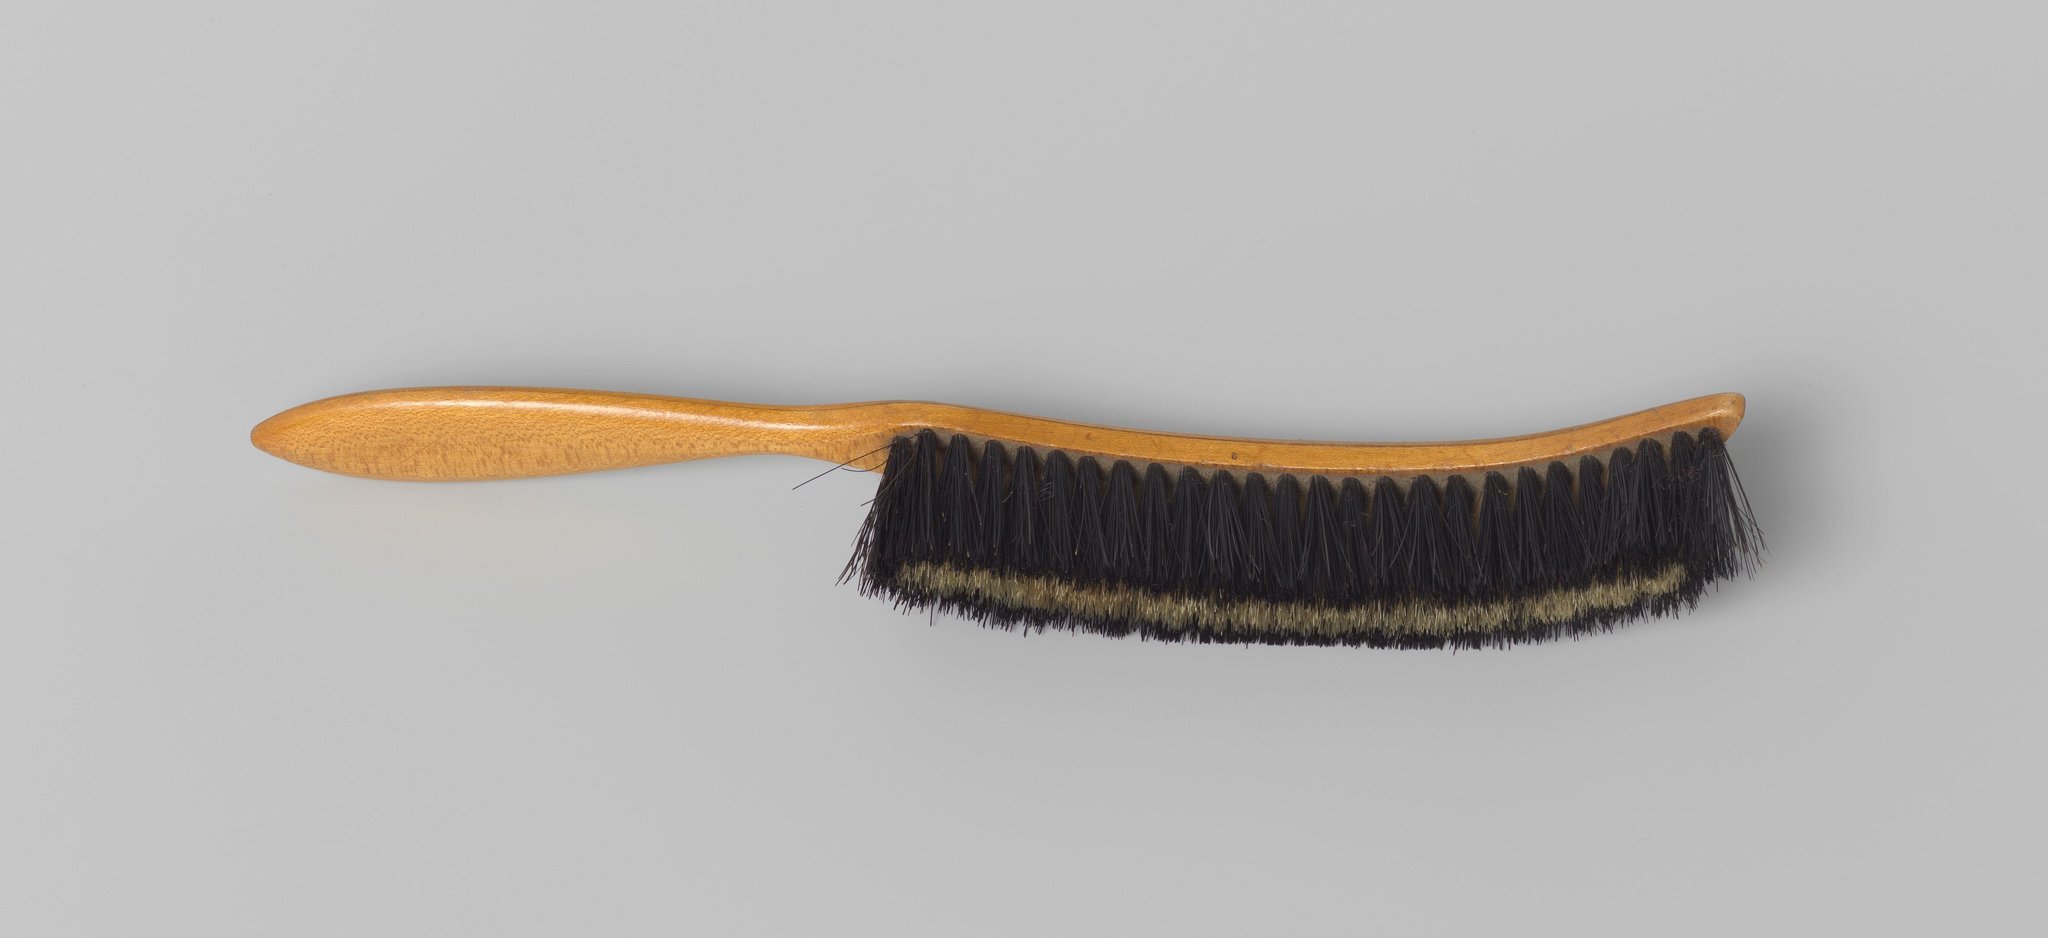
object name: hat brush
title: Hoedenborstel met houten handvat en gekromde borstel waarin zwarte en witte stugge haren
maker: Anonymous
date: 1930-1950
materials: hair, wood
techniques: cutting, varnishing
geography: netherlands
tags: e.j. van der zaal, lisse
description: Hoedenborstel met houten handvat en gekromde borstel waarin zwarte en witte stugge haren. Model: spits toelopend handvat. Gekromd, spits toelopende borstel met lange zwarte haren en in het midden witte haren. De kromming vergemakkelijkt het borstelen van de bol van de hoed.